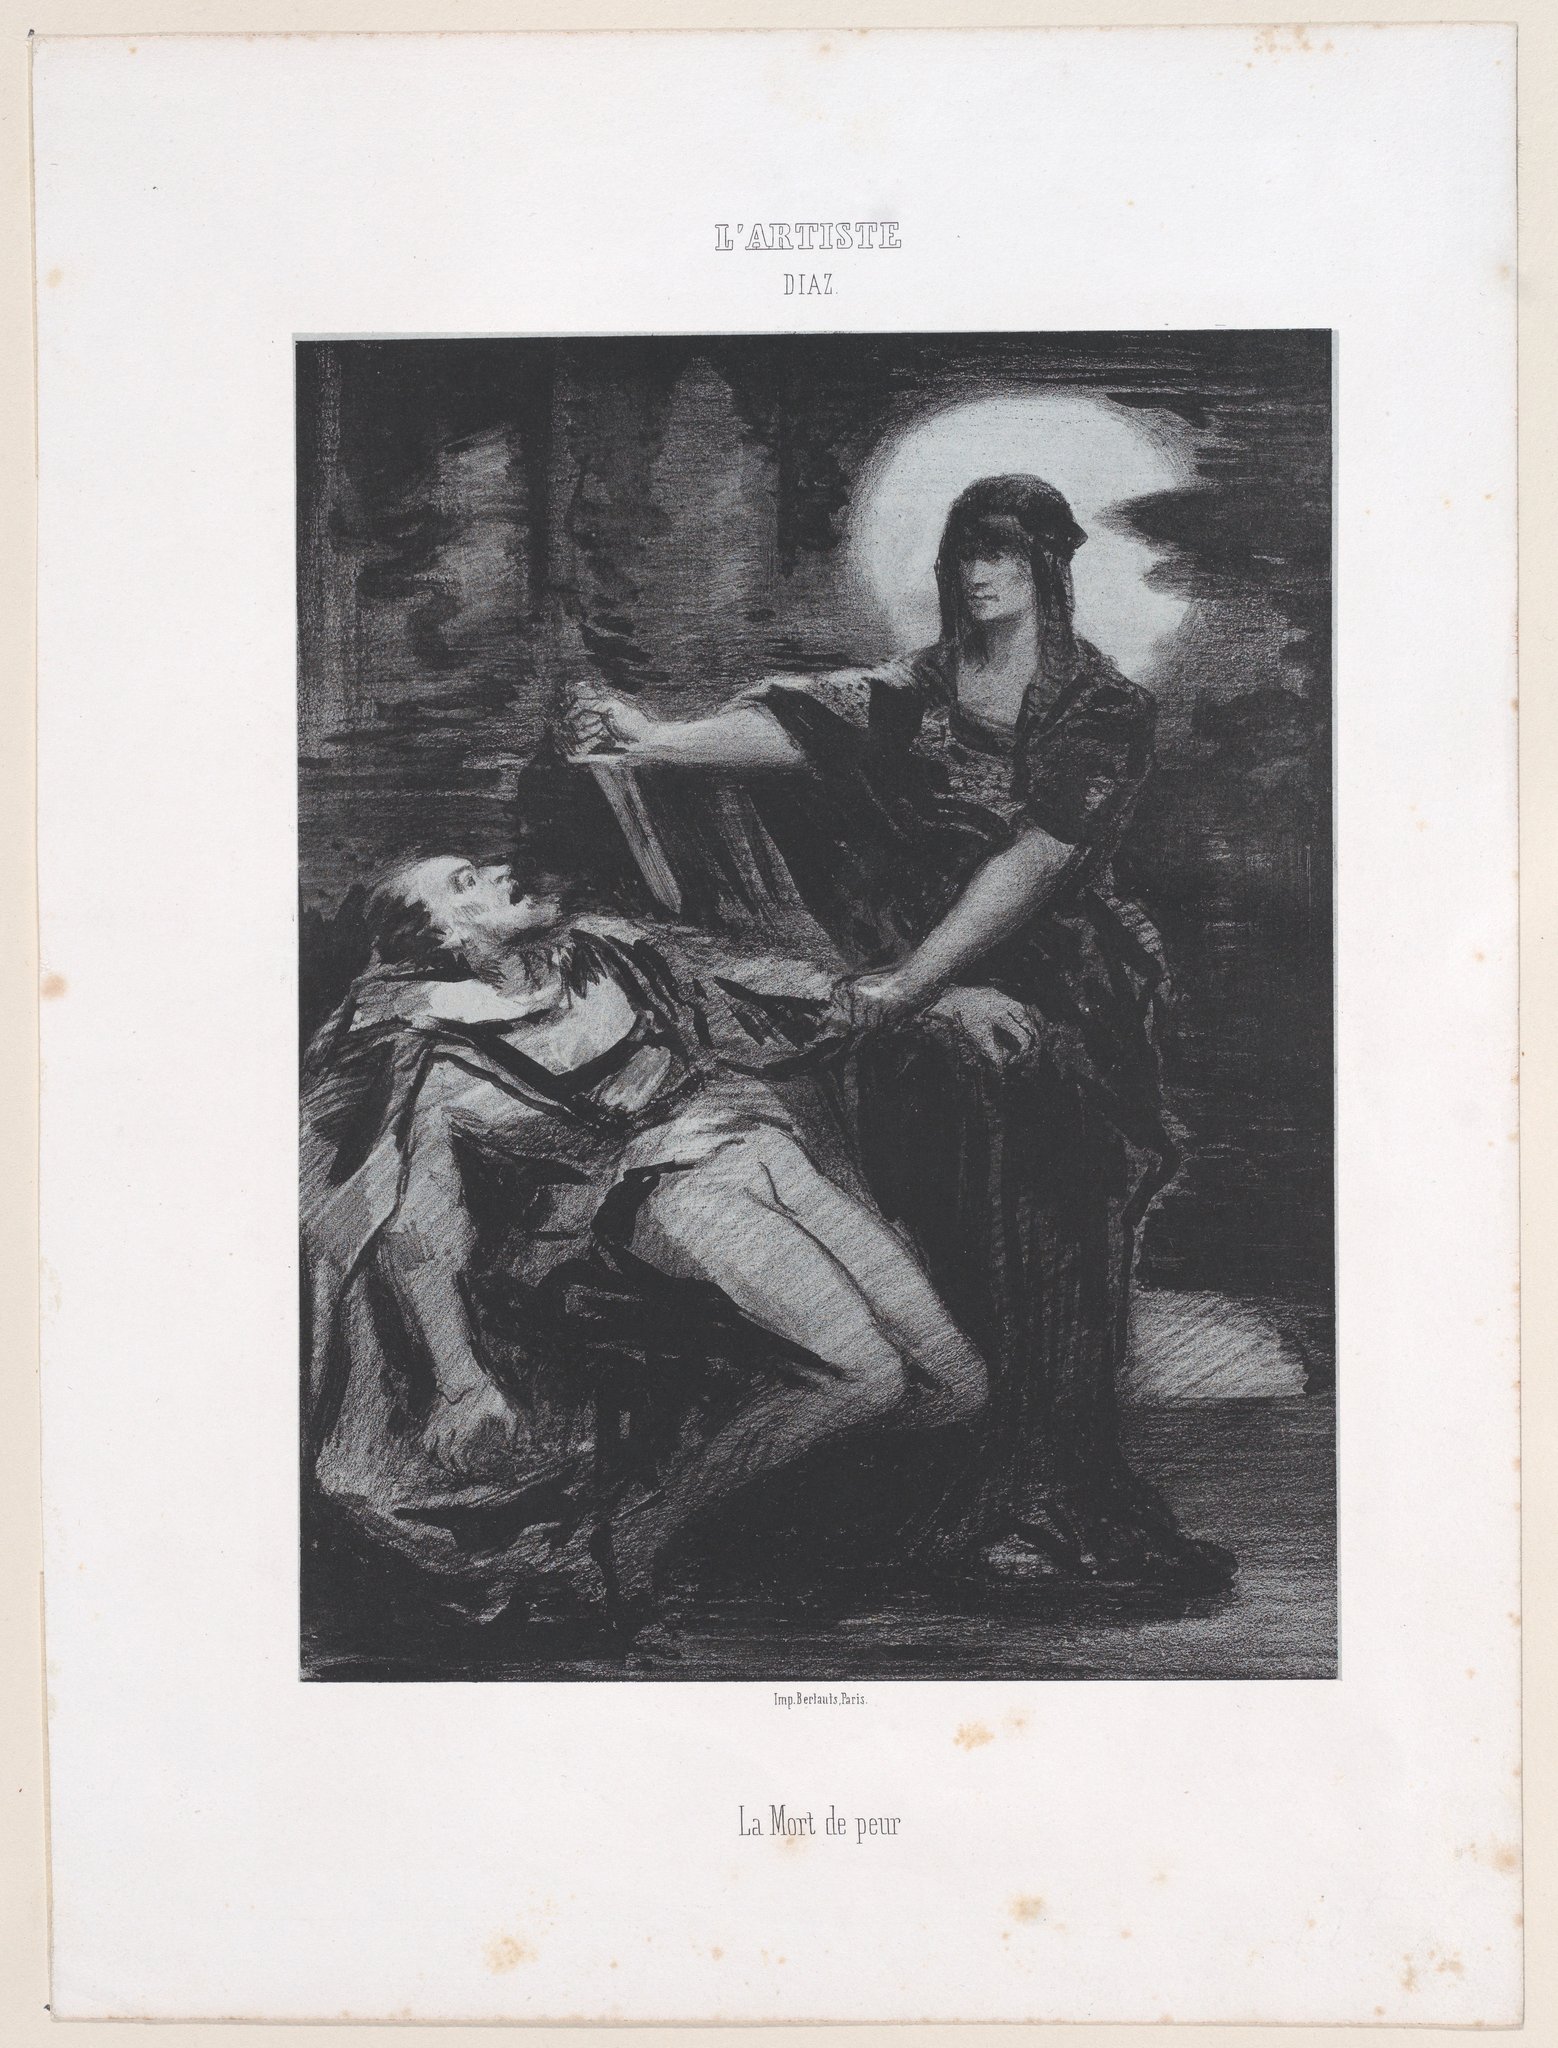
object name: print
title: La Mort de peur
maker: narcisse-virgile diaz de la peña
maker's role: artist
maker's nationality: french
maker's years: 1808-1876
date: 1830-1876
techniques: lithograph